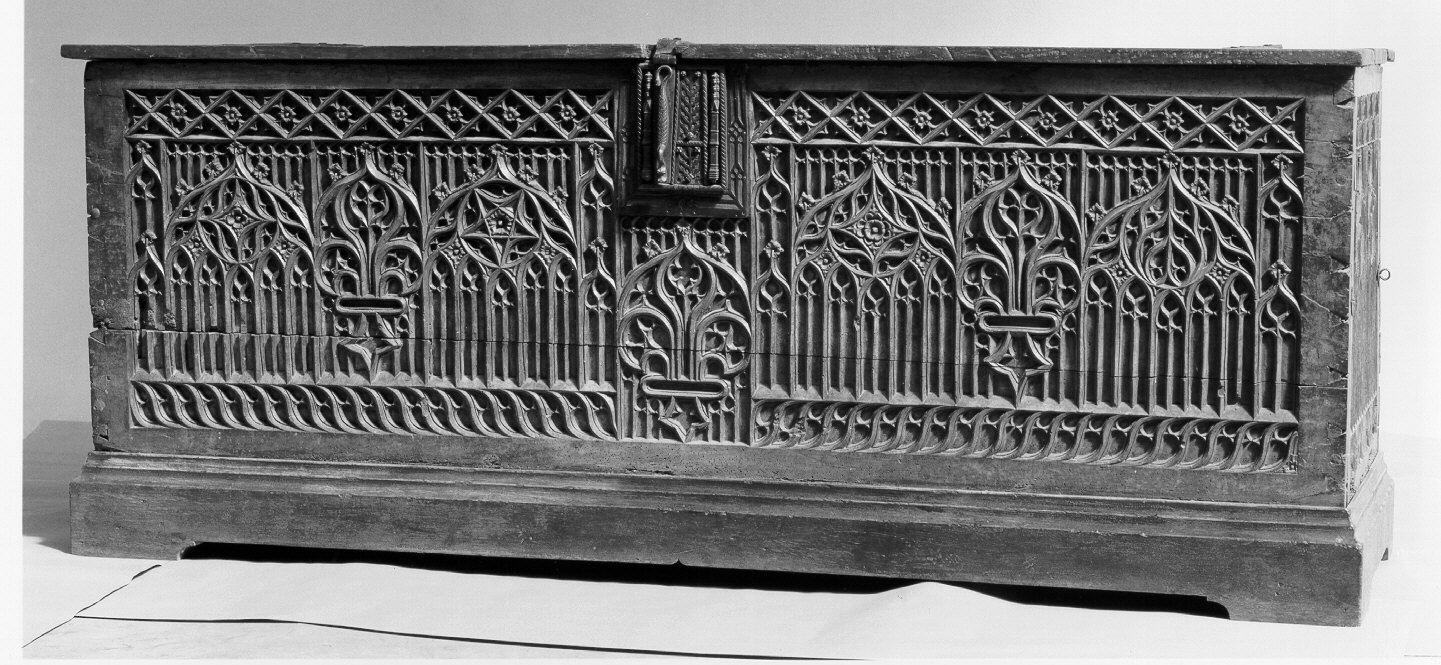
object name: chest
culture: french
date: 1451-1500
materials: iron, wood